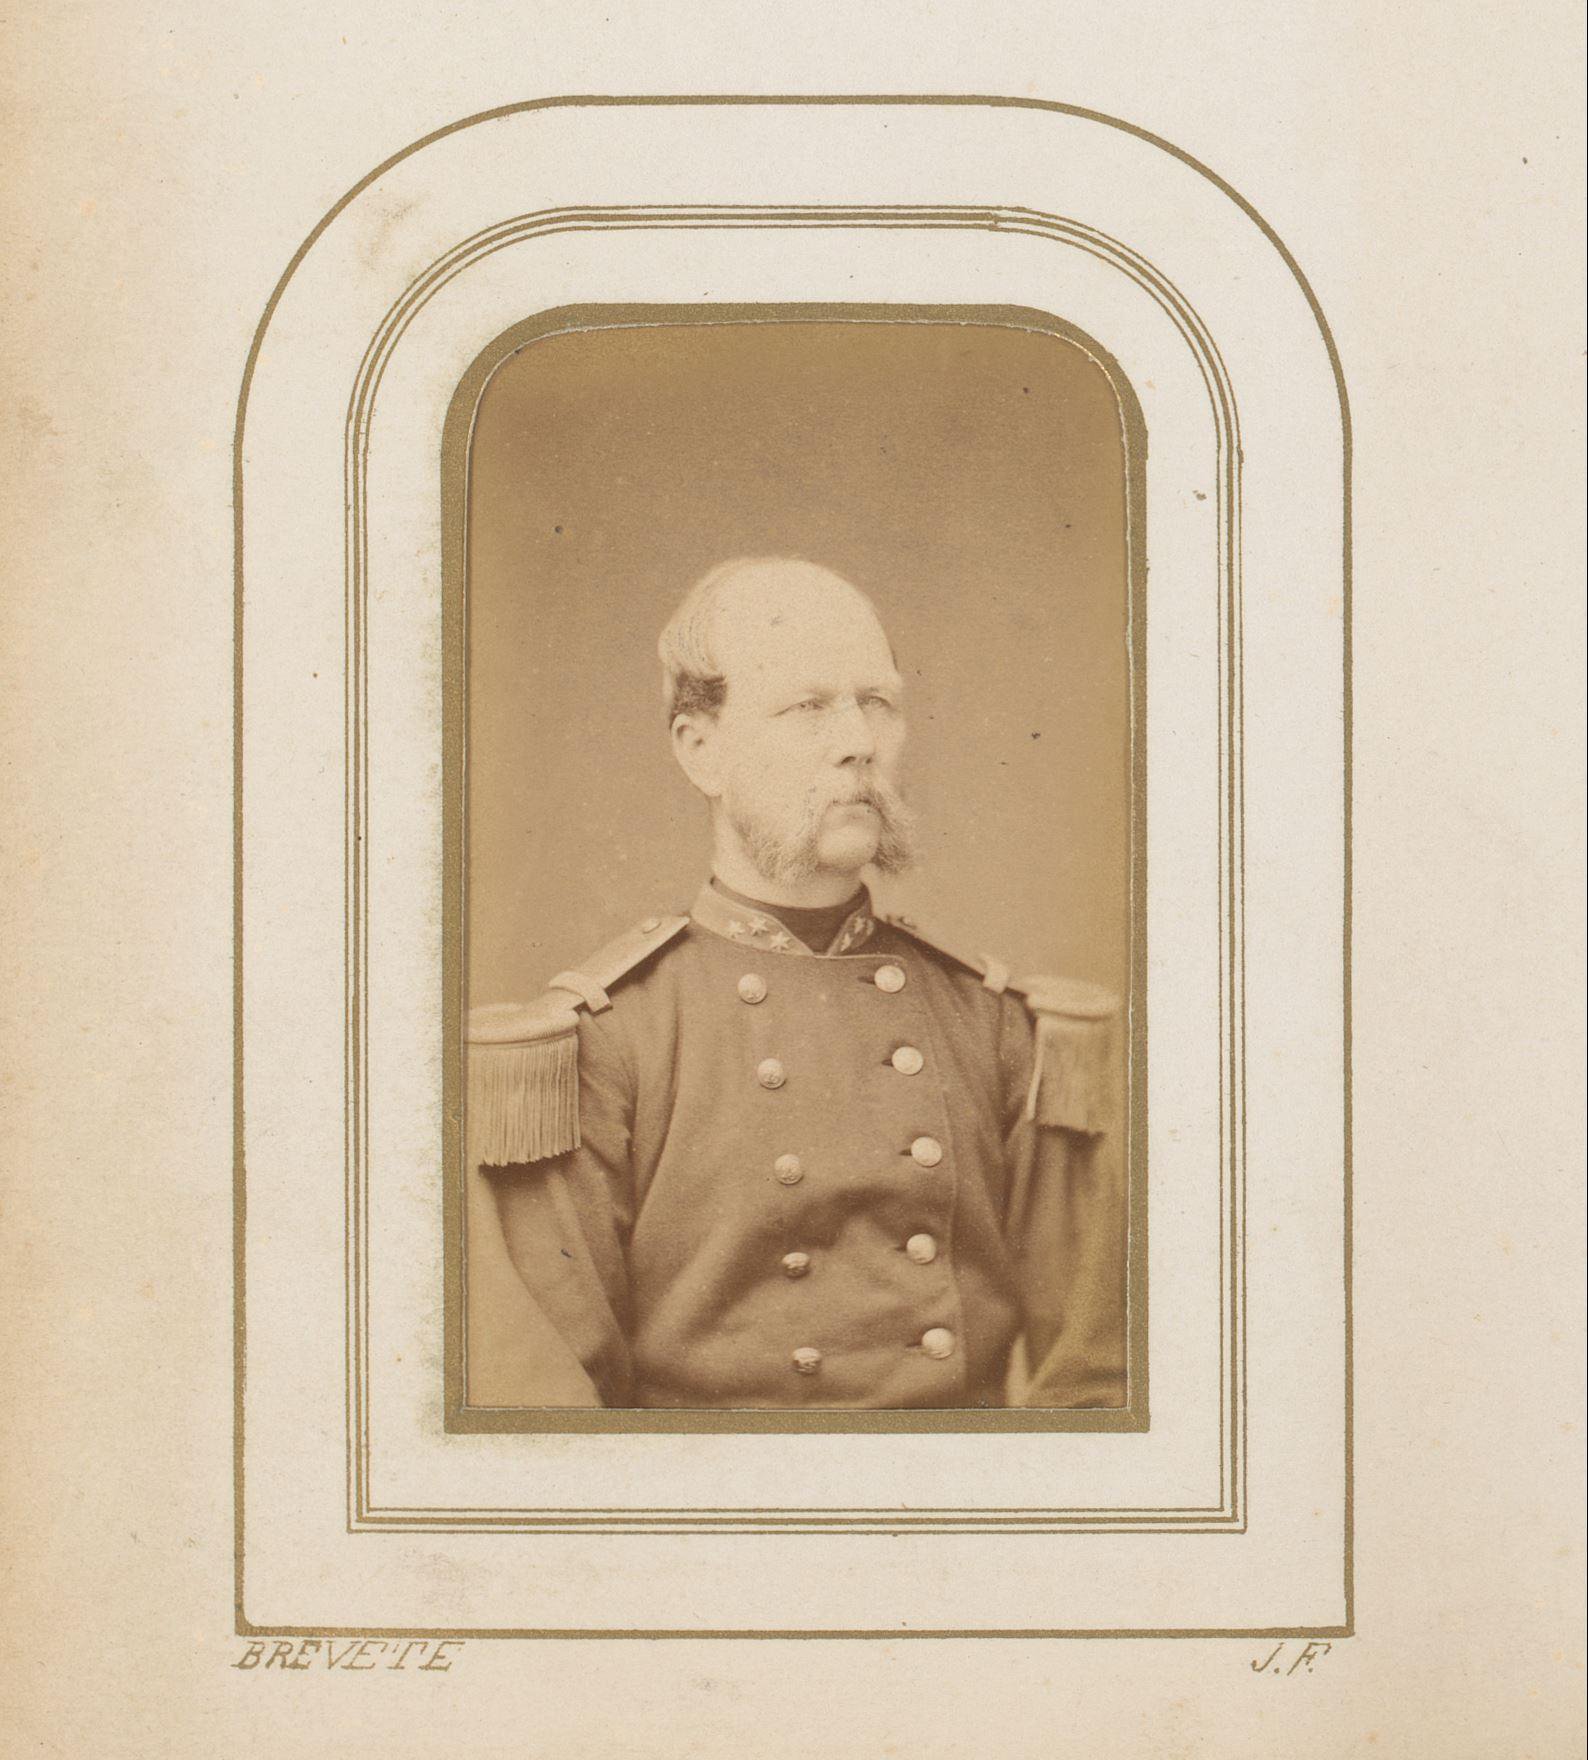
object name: photograph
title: Portret van een man met snor in uniform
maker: auguste chapuis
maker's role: fotograaf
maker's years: 1837-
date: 1868-1888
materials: cardboard, photographic support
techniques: albumen print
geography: bergen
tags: moustache, historical persons, (military) uniforms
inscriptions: inscription: ‘Photographie du Hainaut/ Chapuis/ 15, rue du seminaire/ en face de l'athenée/ Mons’, annotation: ‘A Monsieur le [lieut-colonel]/ Lemoine commandant le 13e/ régiment de ligne/ [...]’